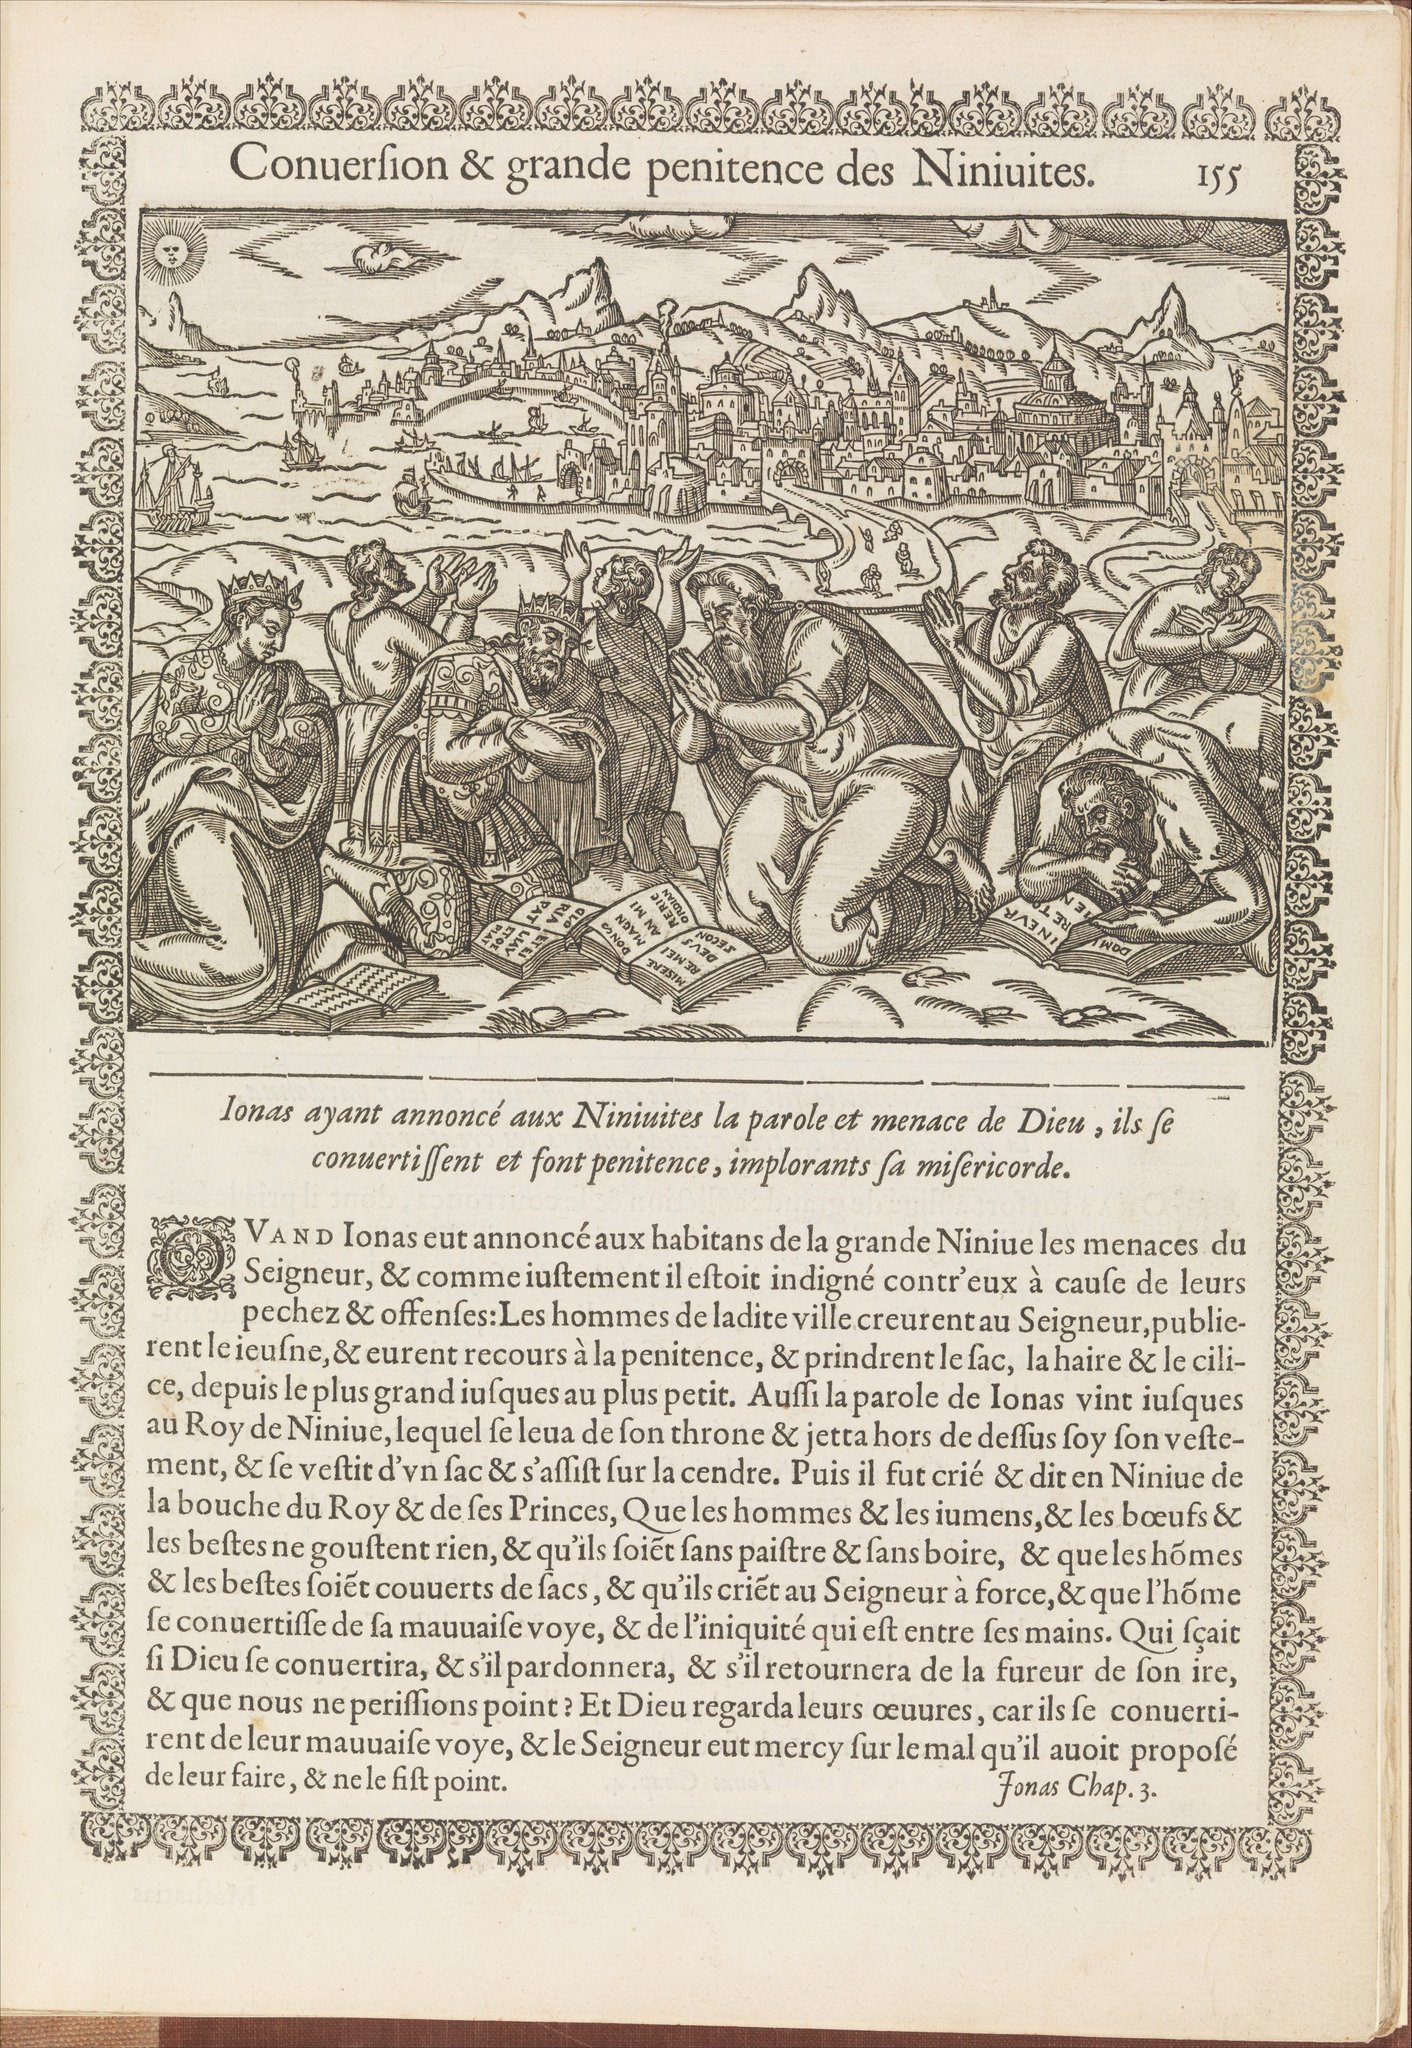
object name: book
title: Figures Historiques du Vieux Testament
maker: jean cousin the younger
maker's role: artist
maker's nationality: french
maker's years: 1522-1594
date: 1614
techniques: woodcut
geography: france